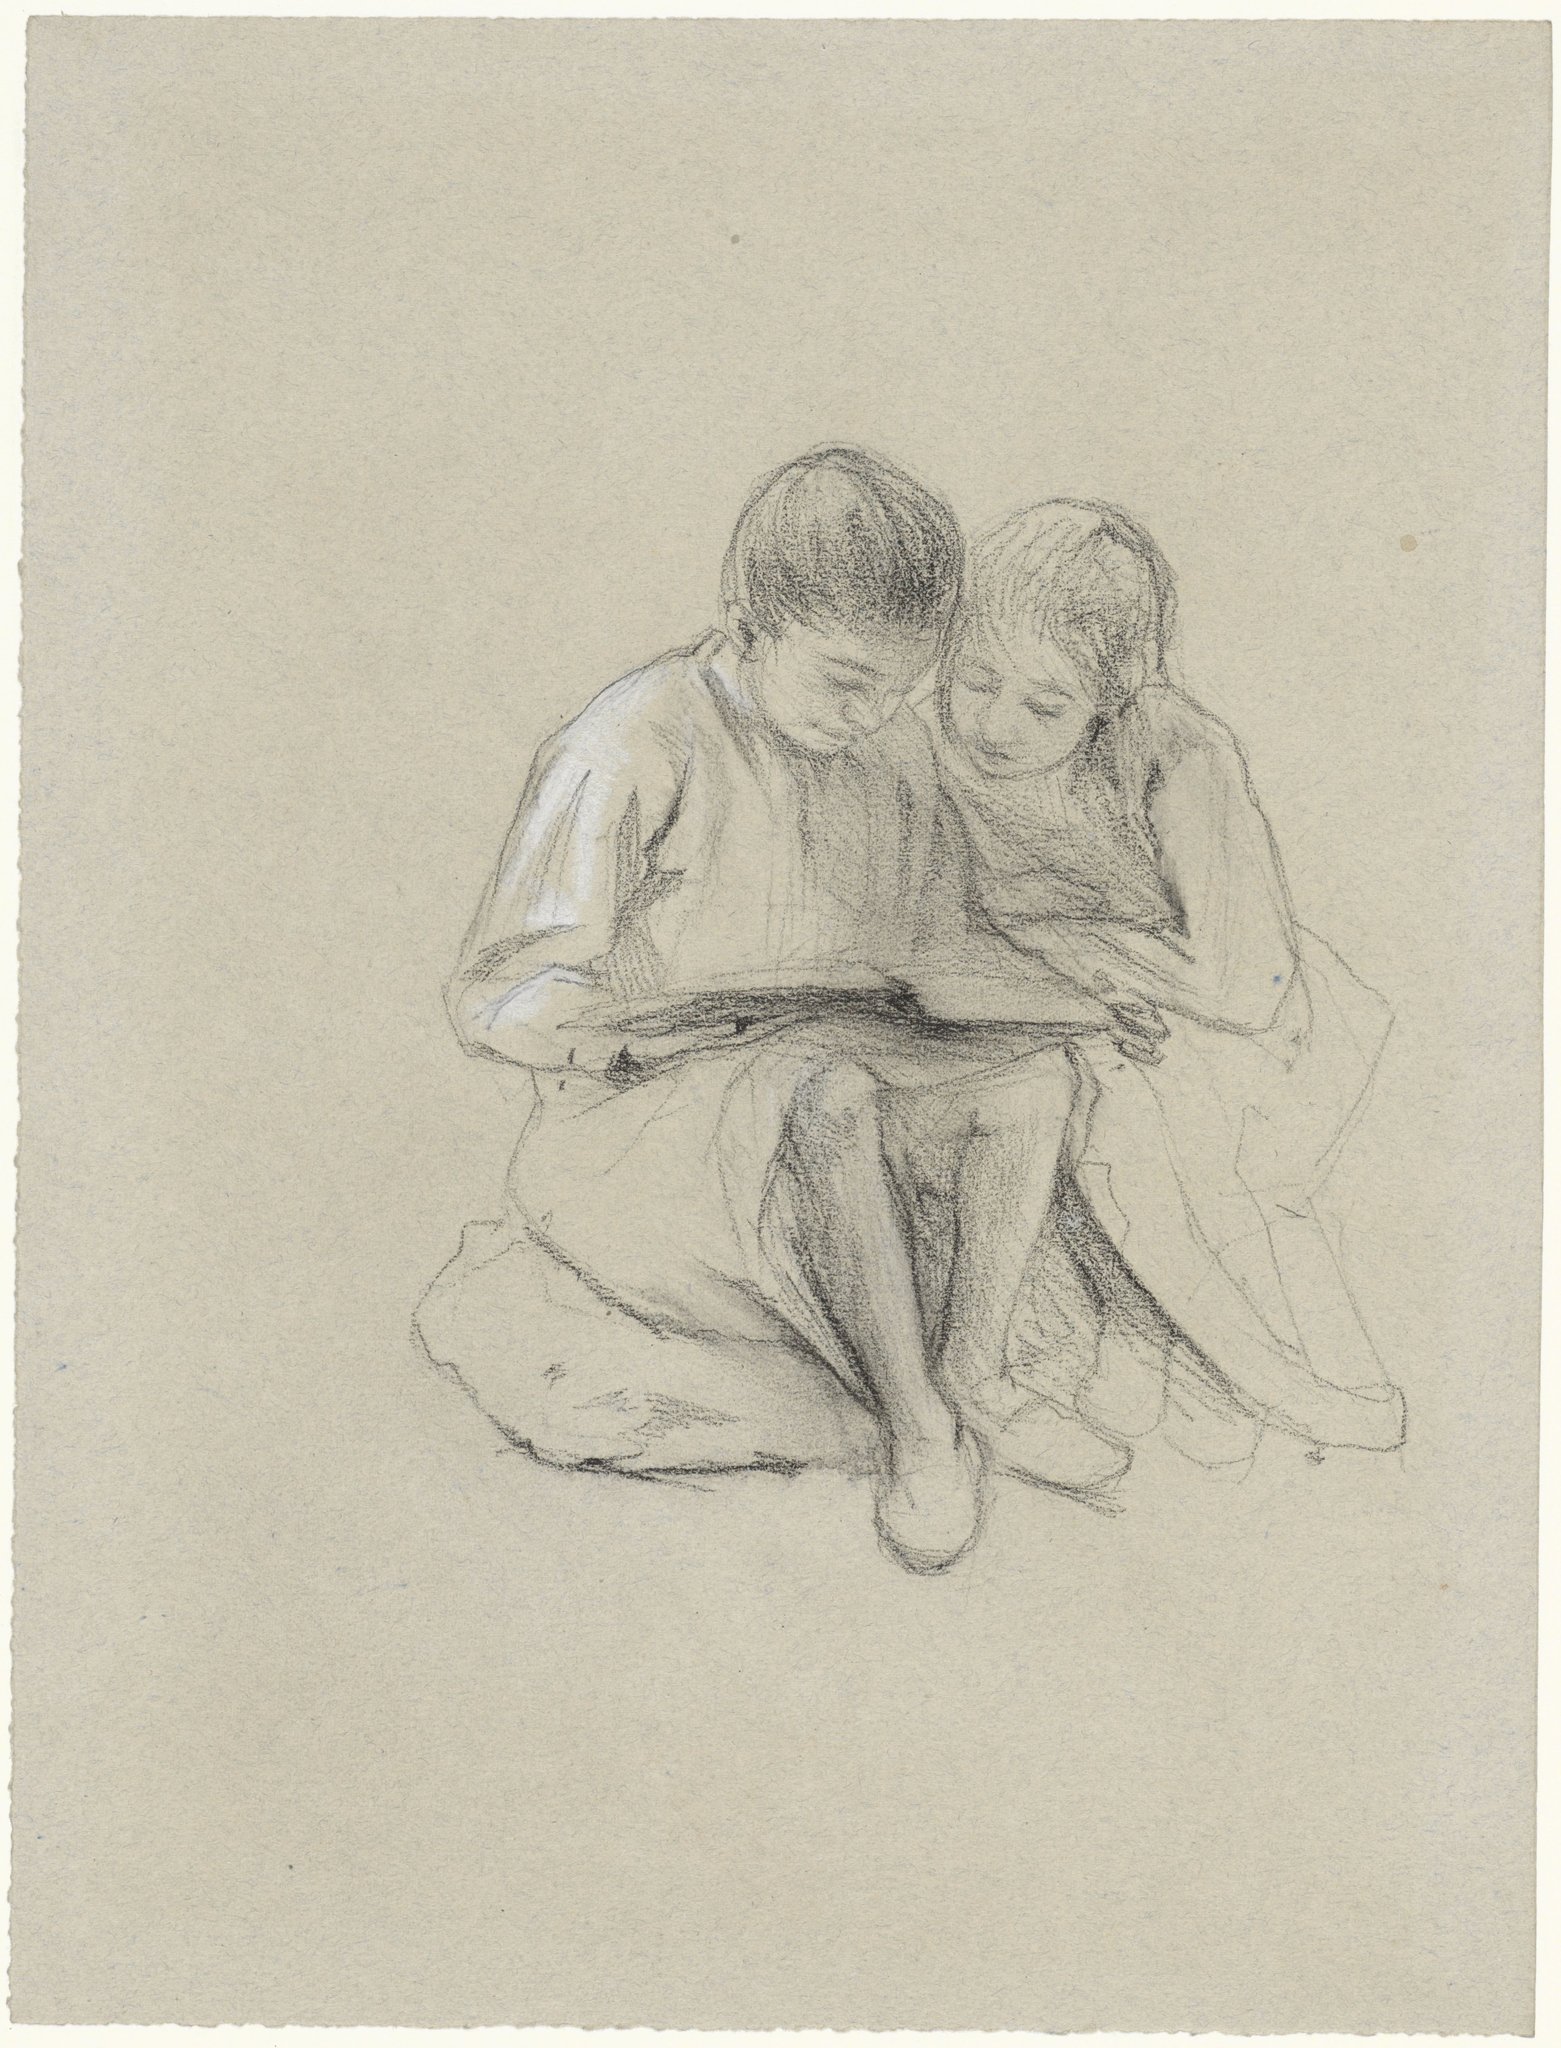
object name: drawing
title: Twee lezende kinderen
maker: a.a.l. de grammont-hubrecht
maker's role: draughtsman, painter, print maker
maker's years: 1855-1913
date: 1865-1913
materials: chalk, paper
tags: reading